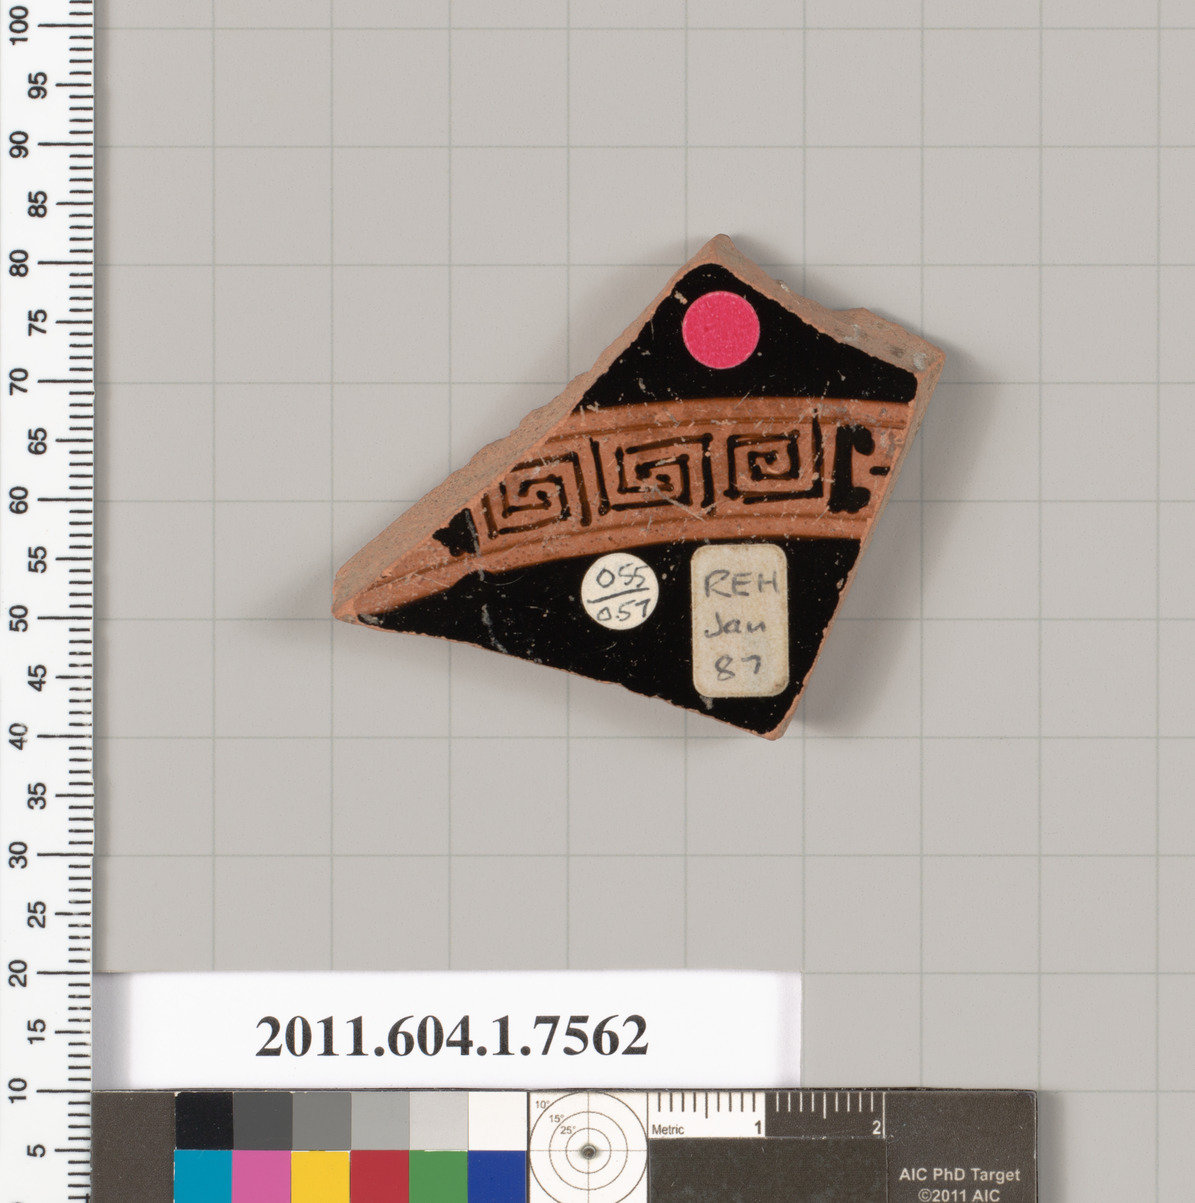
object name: kylix fragment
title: Terracotta fragment of a kylix (drinking cup)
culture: greek, attic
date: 460-450 BCE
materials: terracotta